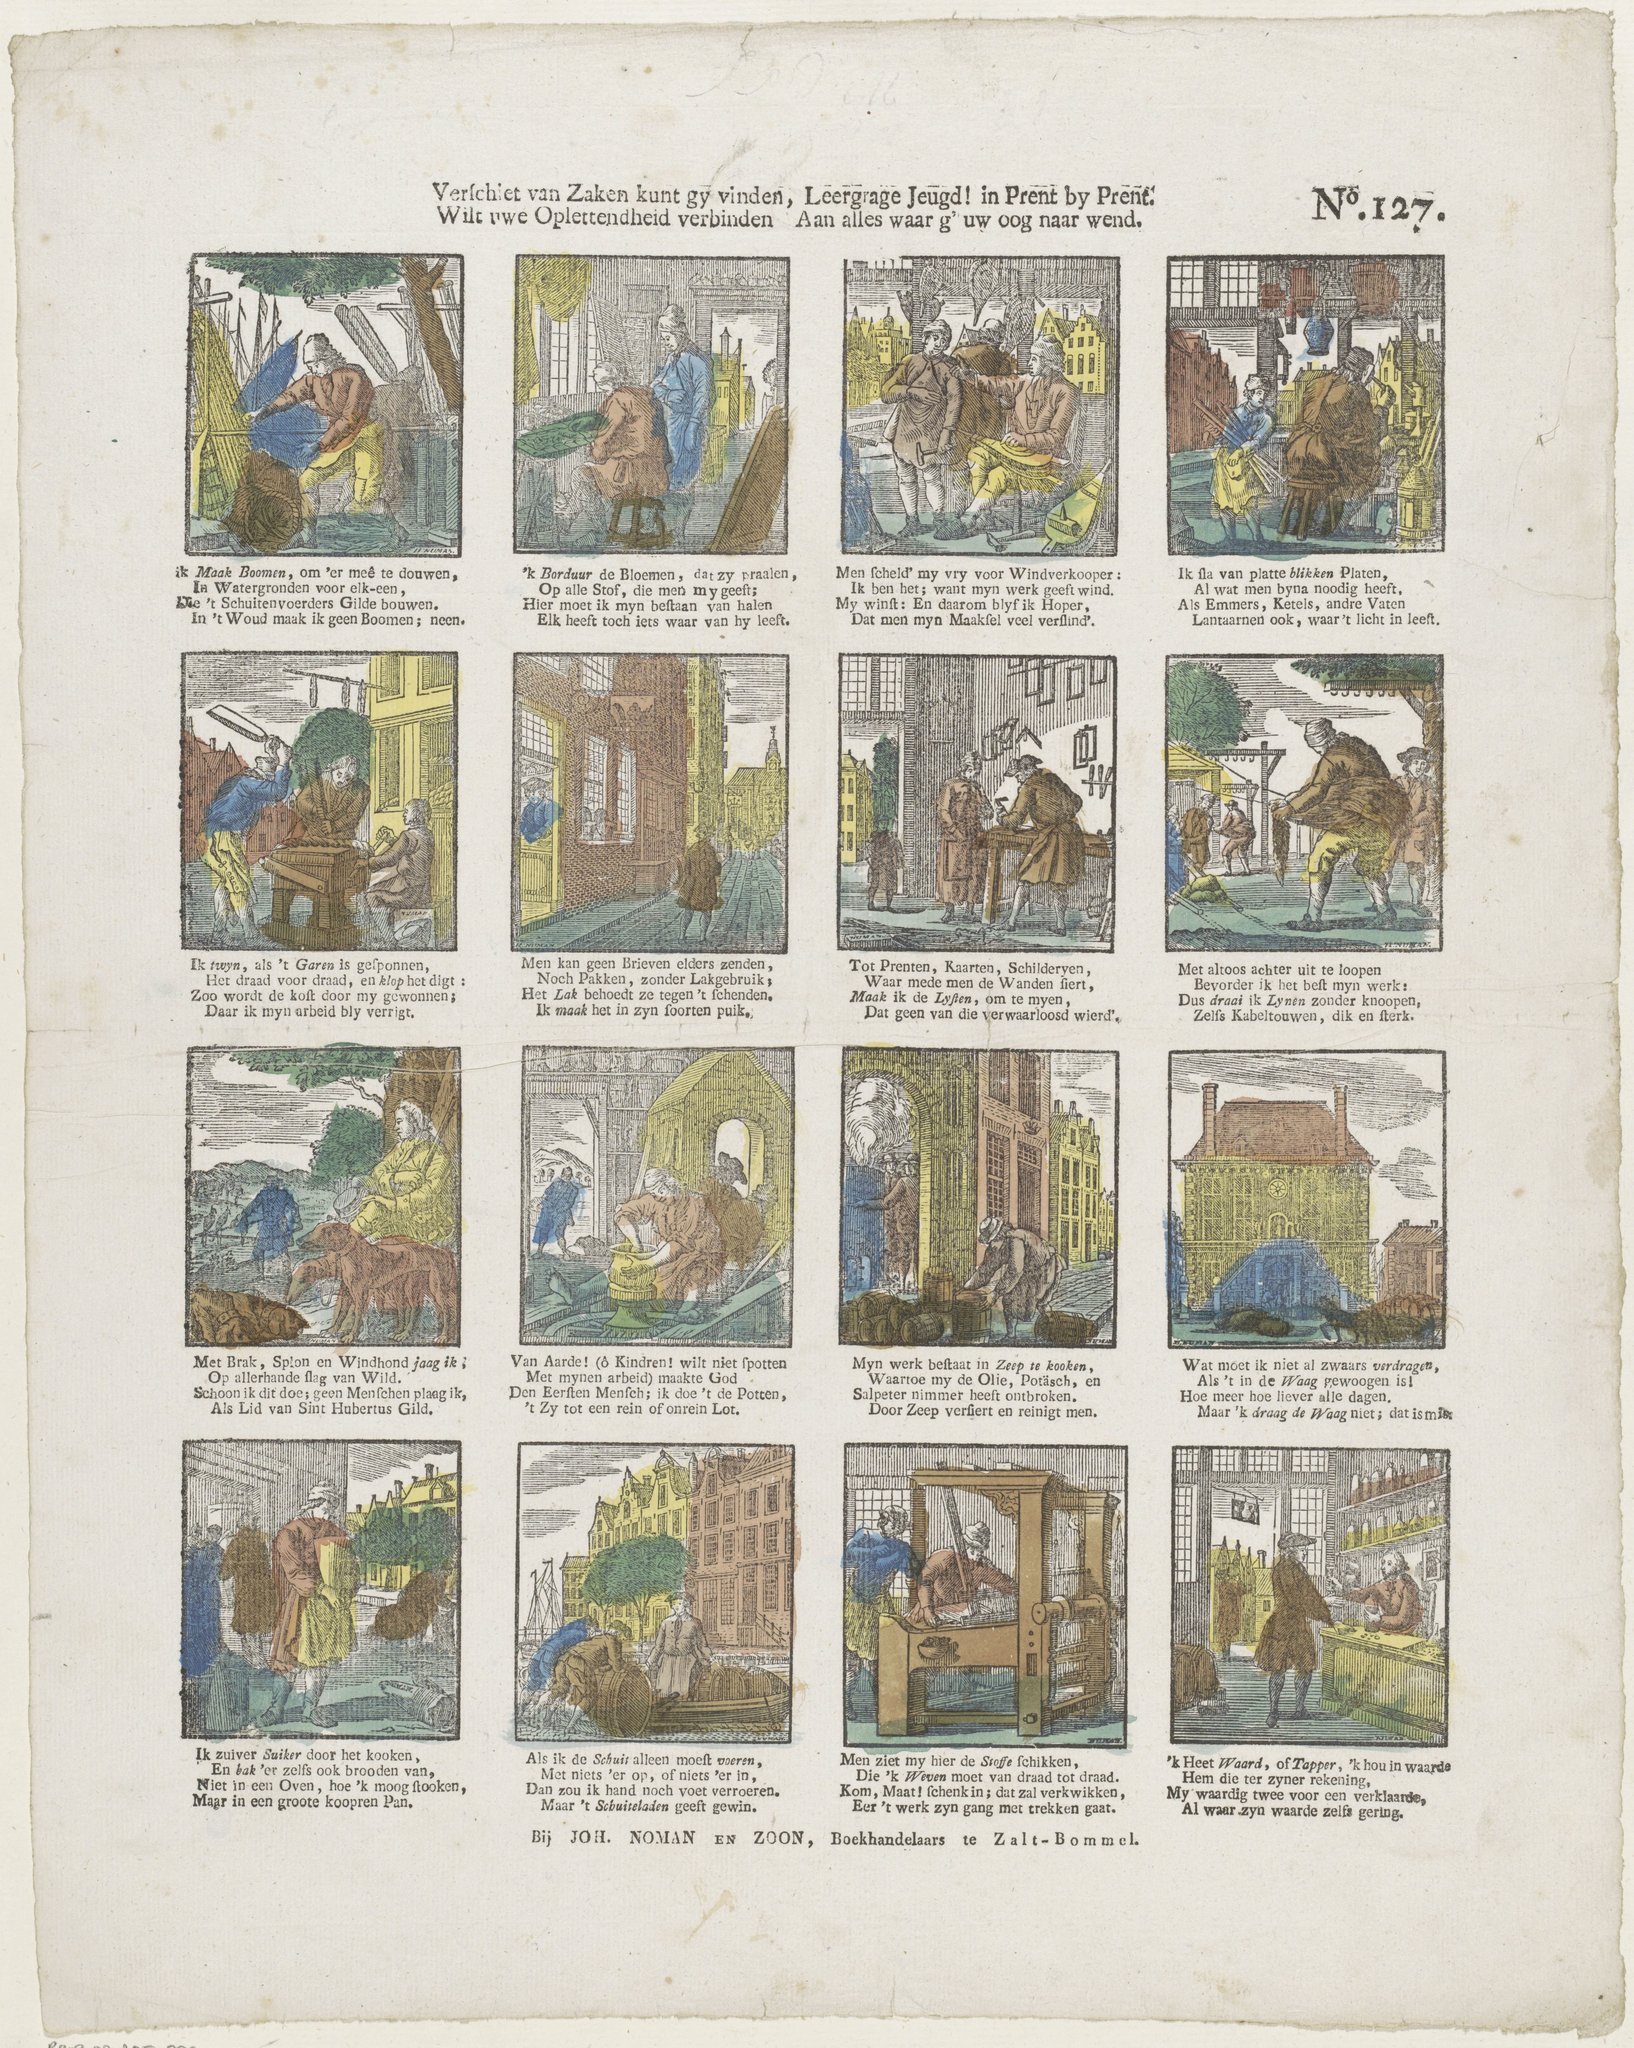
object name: popular print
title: Verschiet van zaken kunt gy vinden, / Leergraage jeudg! in prent by prent. / Wilt uwe oplettend heid verbinden / Aan alles waar g uw oog naar wend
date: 1830-1892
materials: paper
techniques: colour, letterpress printing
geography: zaltbommel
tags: craft-production, skilled handiwork, crafts and industries, potter, ceramist, sewing, tapestry weaver, gobelin maker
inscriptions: collector's mark: Lugt 2760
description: Blad met 16 voorstellingen van ambachtslieden en beroepen, zoals jager, pottenbakker en wever. Onder elke afbeelding een vierregelig vers. Genummerd rechtsboven: No. 127.